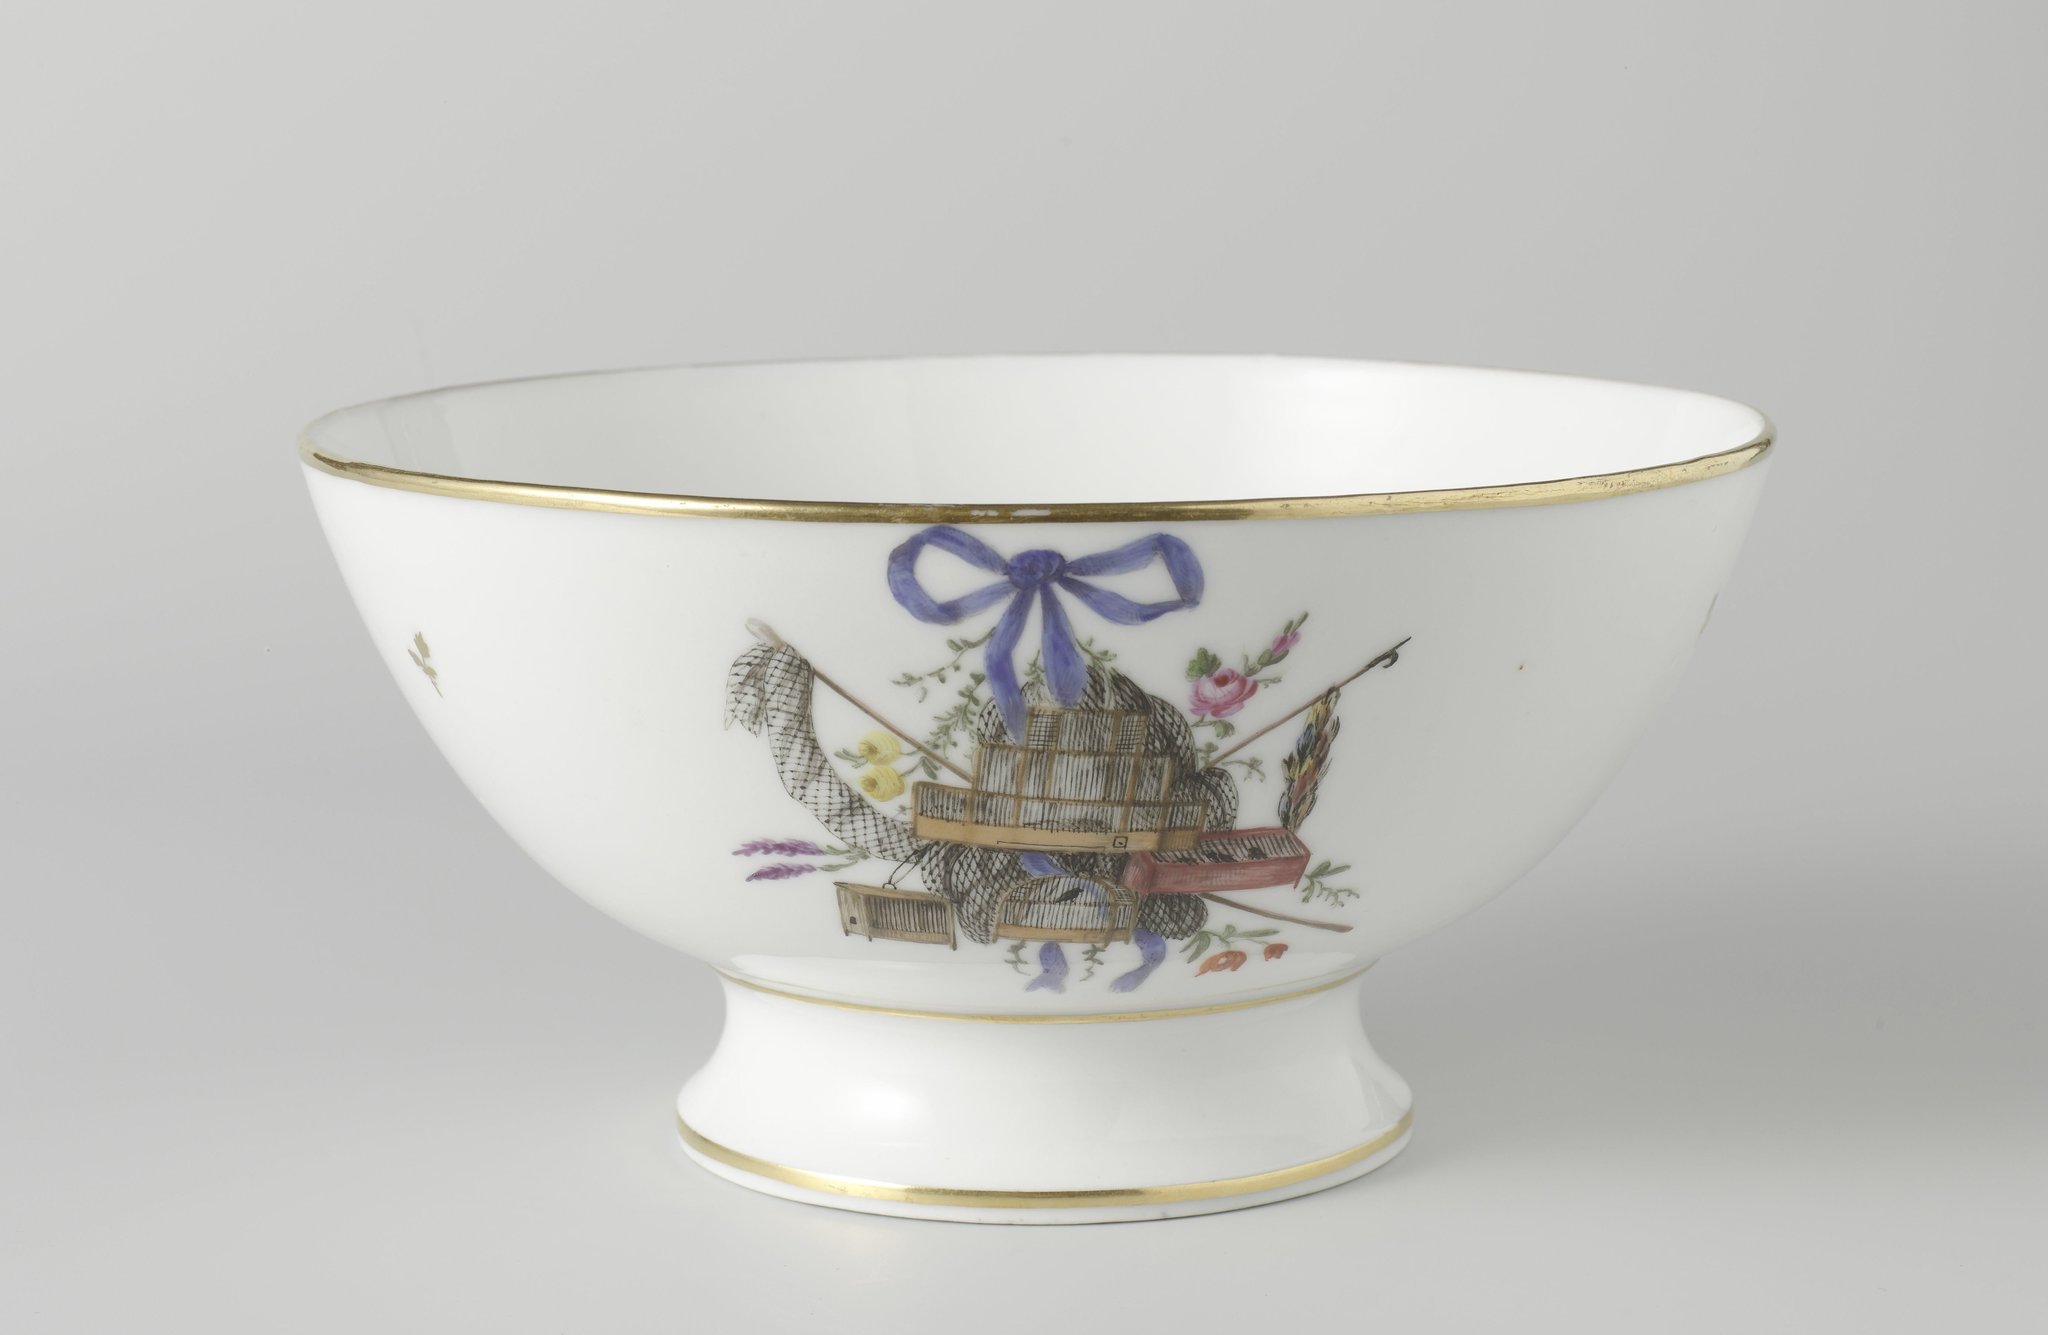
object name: slop bowl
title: Spoelkom met decoratie van trofeeën aan gestrikte linten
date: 1809-1814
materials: porcelain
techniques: painted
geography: nieuwer-amstel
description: Theeservies bestaande uit een theepot, een suikerpot, een spoelkom en twaalf koppen en schotels veelkleurig beschilderd met trofeeën hangend aan blauwe strikken. De trofeeën hebben betrekking op diverse beroepen. Gemerkt in zwart: Amstel (de suikerpot Amstel N. 805 en ingegrift A). Verschillende ingegrifte merken in de koppen en schotels.